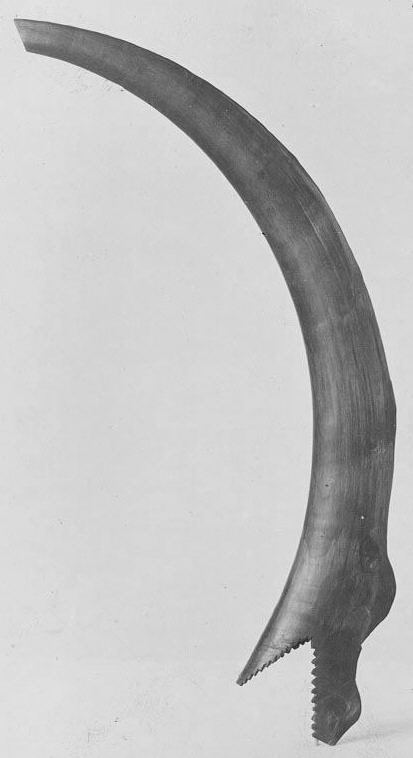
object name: horn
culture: congolese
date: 1867-1900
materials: horn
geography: upper congo